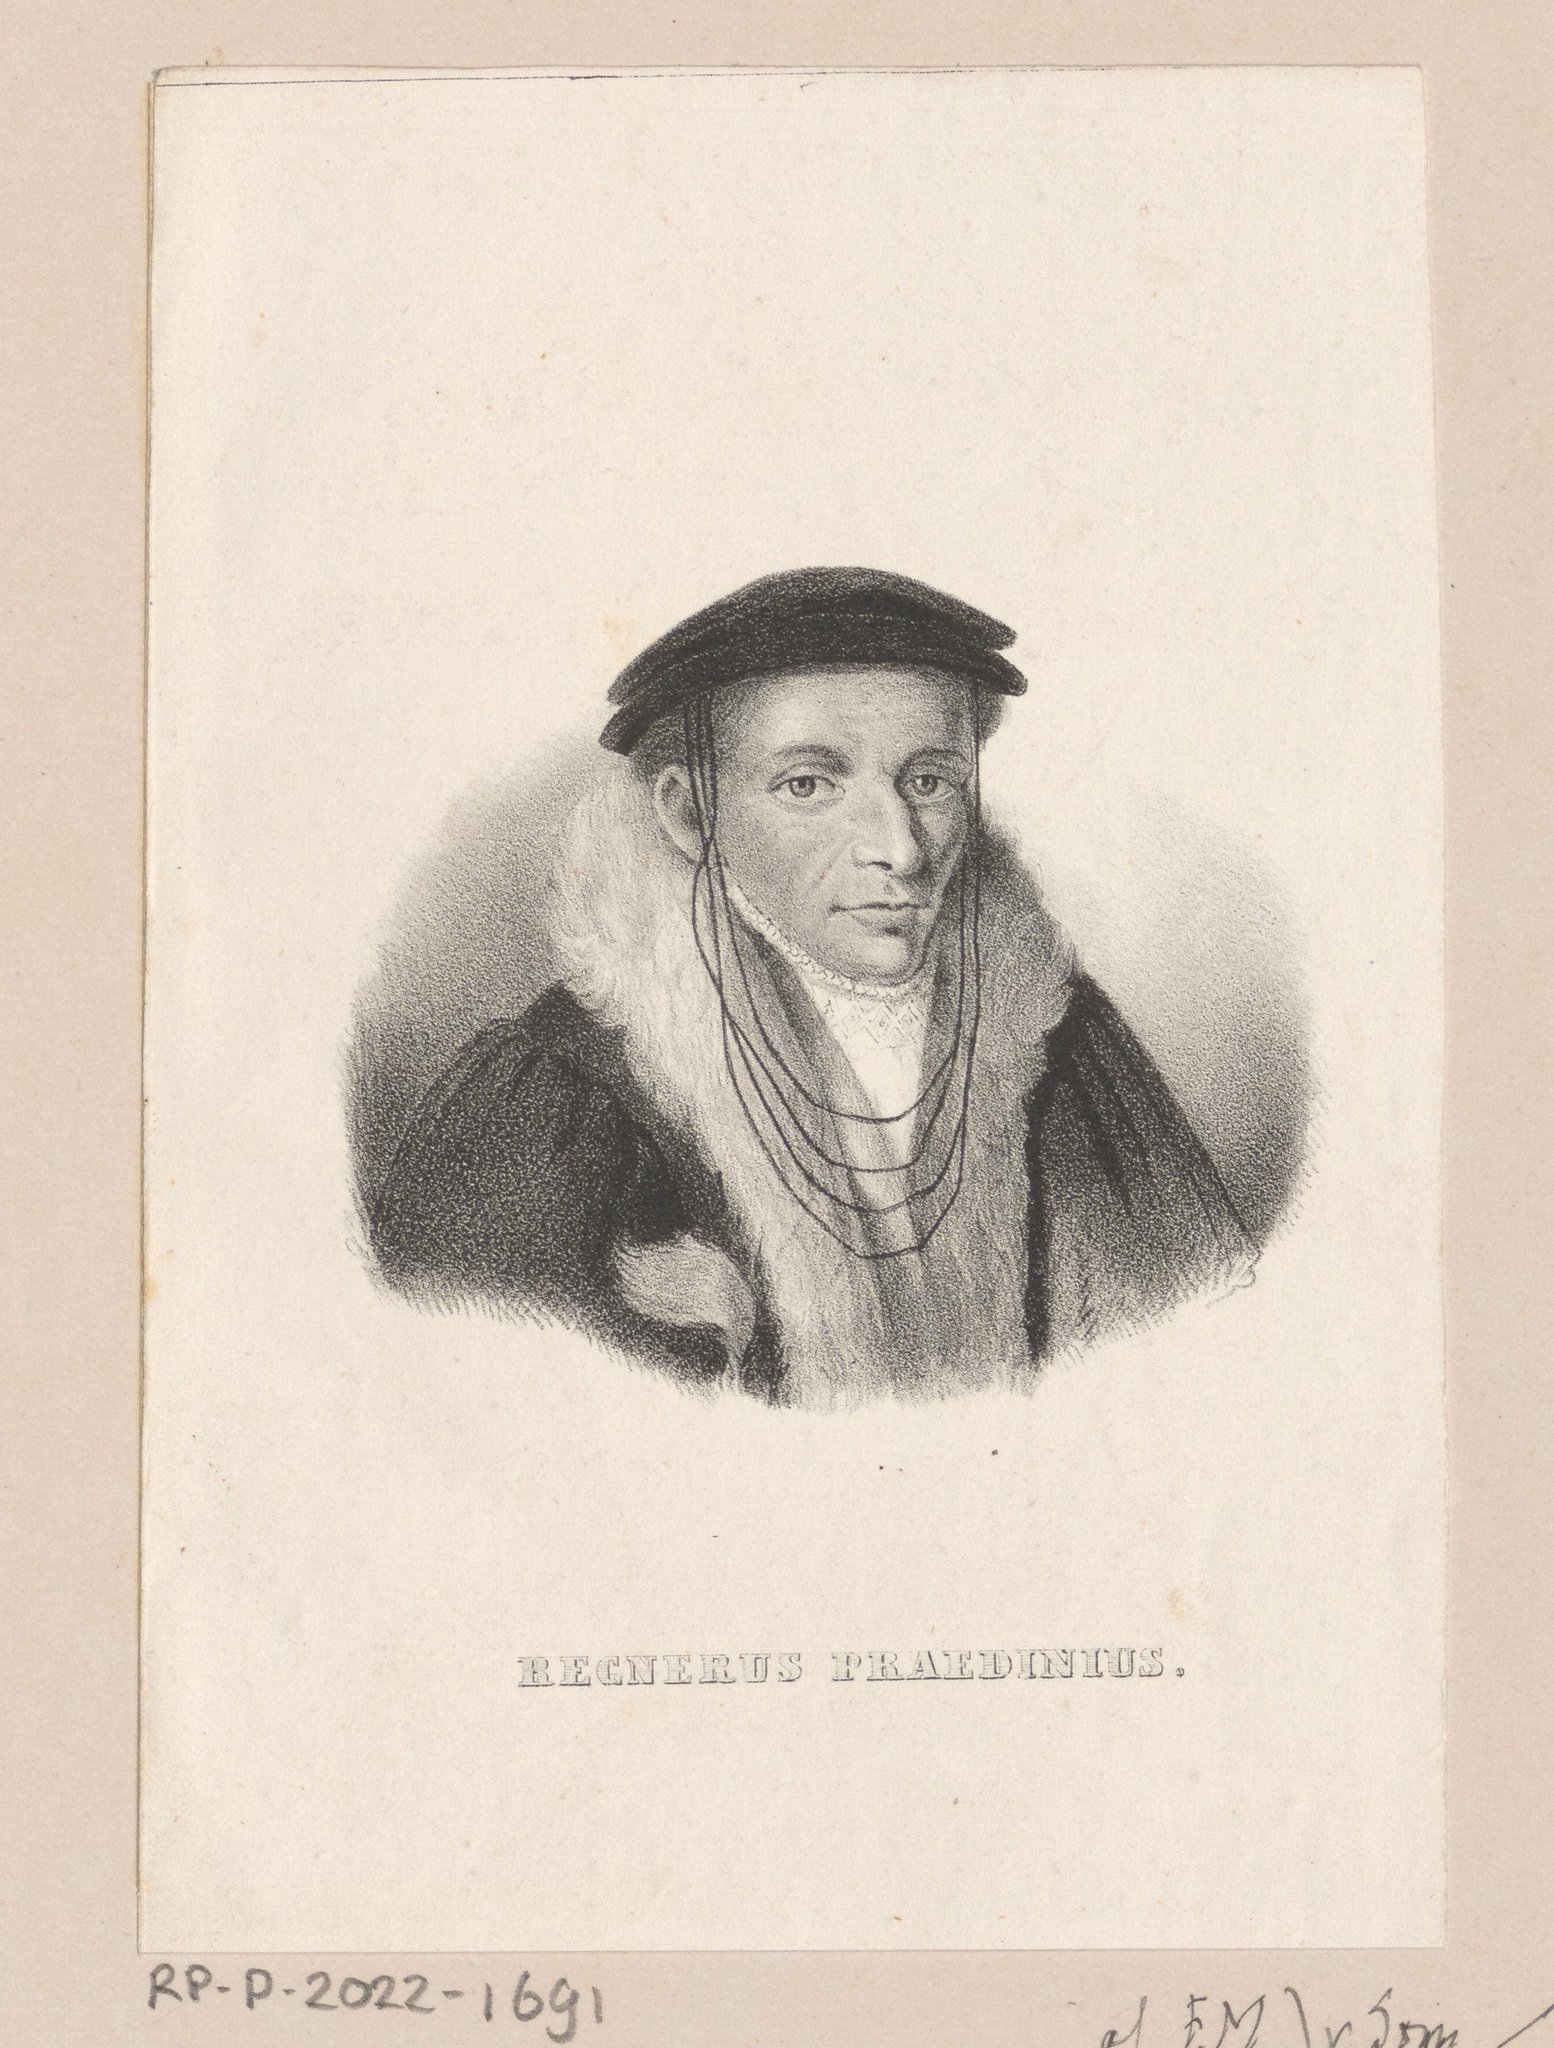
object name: print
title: Portret van Regnerus Praedinius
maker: Anonymous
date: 1789-1850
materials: paper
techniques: lithograph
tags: historical persons, professor